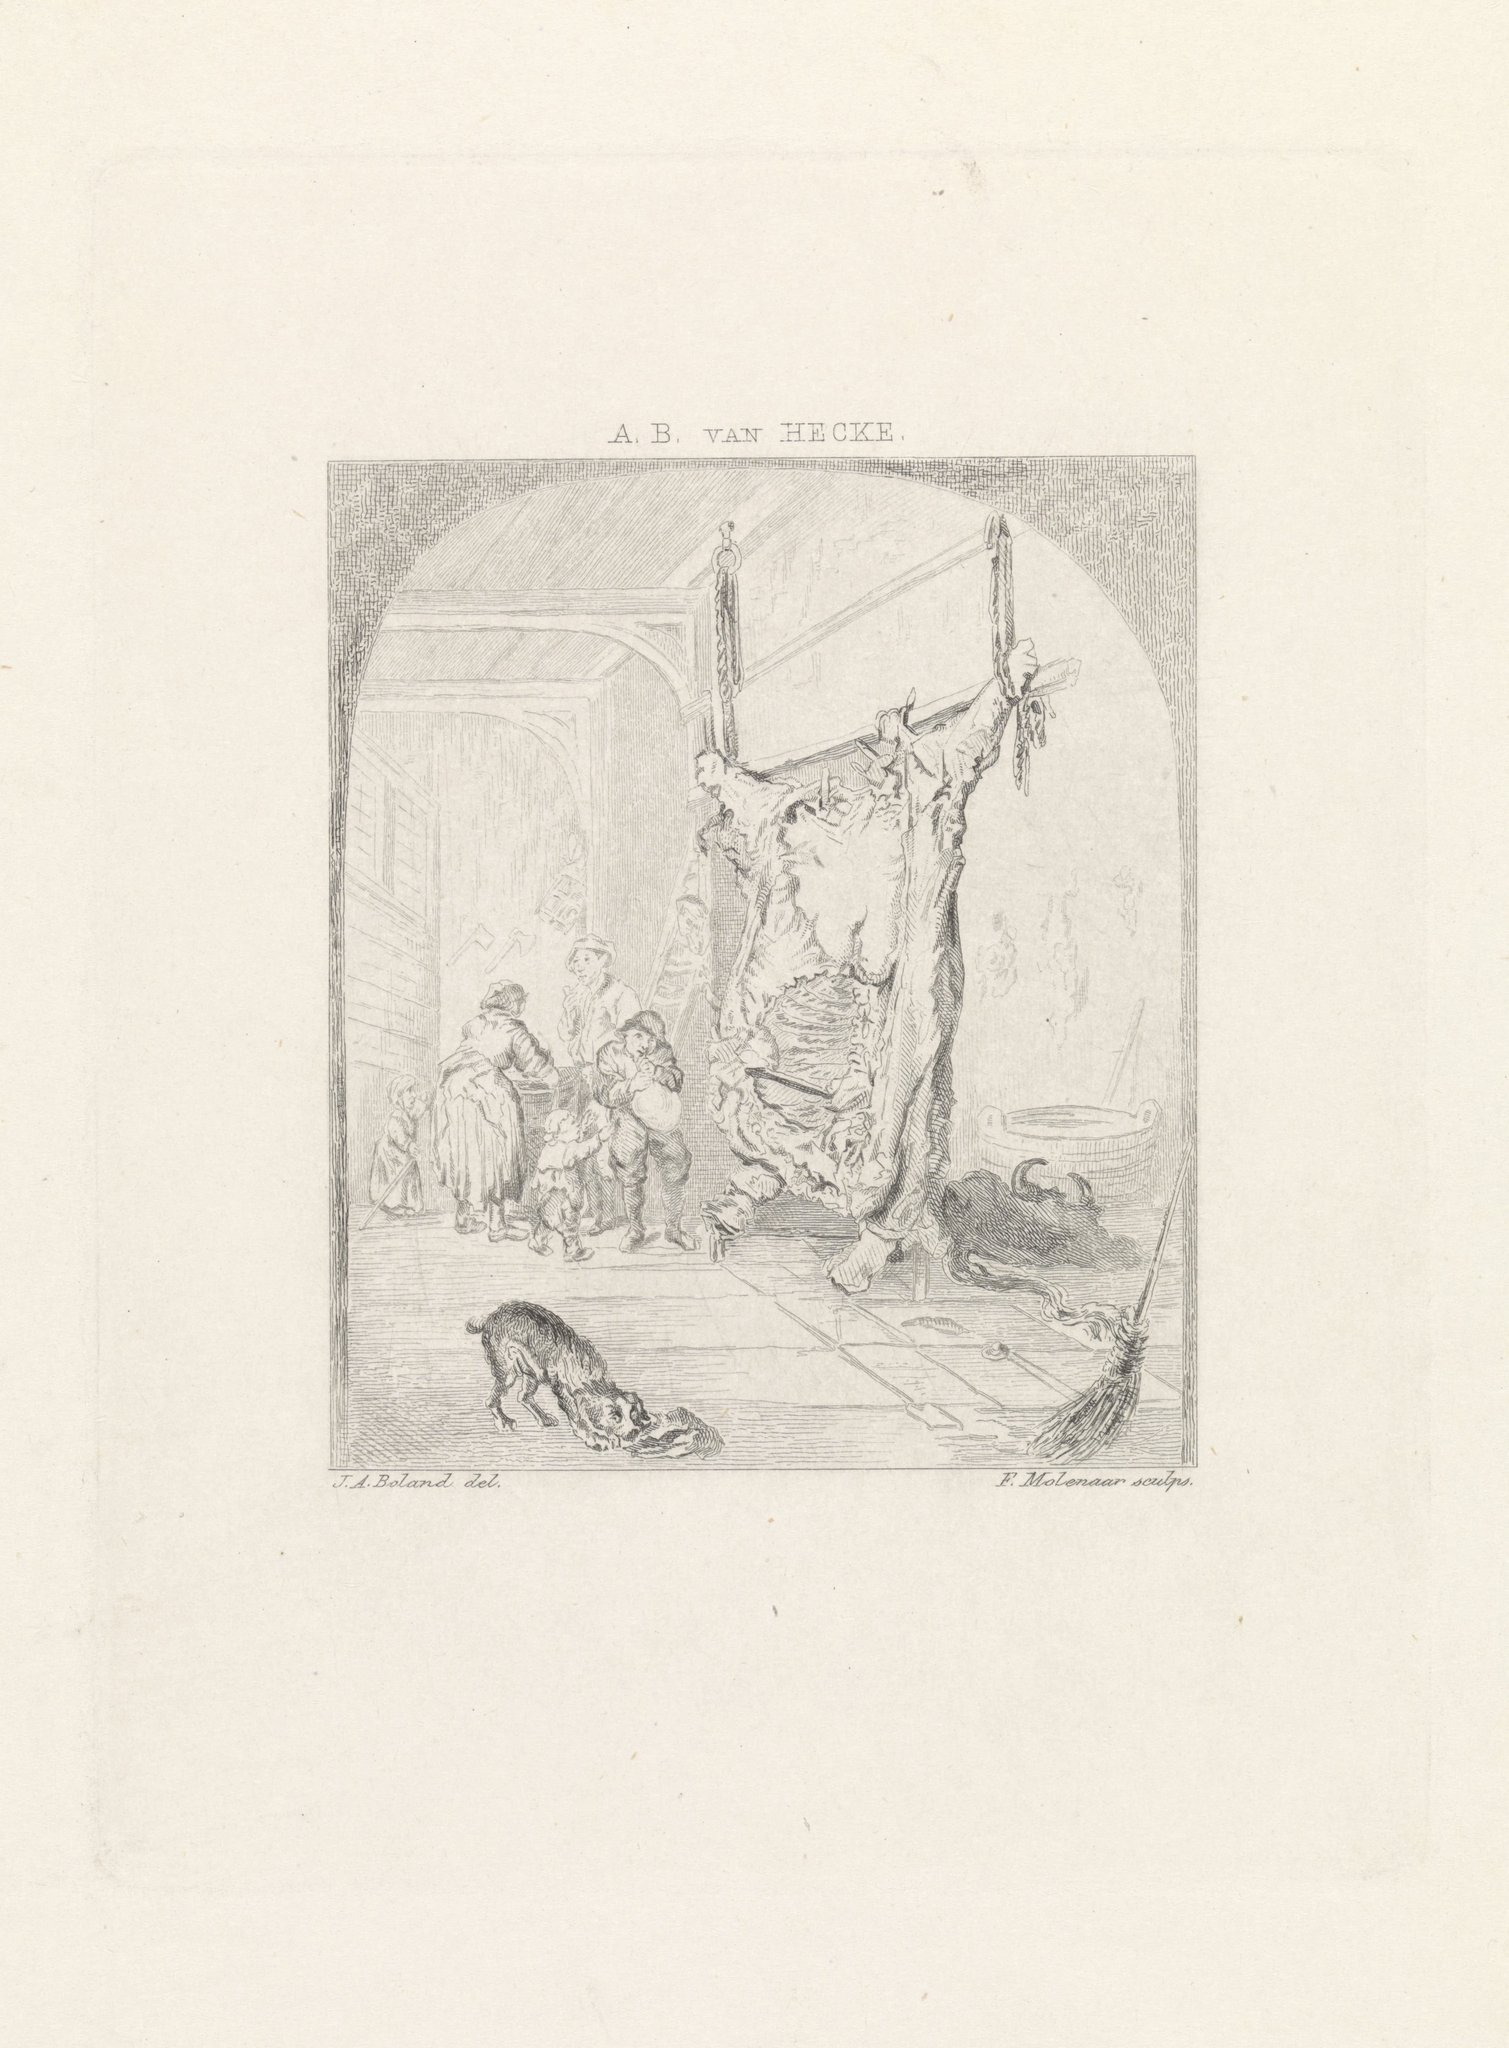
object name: print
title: Geslachte os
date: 1831-1886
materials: paper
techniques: etching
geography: amsterdam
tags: slaughtered ox or pig, dog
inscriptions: collector's mark: Lugt 2228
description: Interieur met een geslachte os hangend aan touwen aan het plafond. Op de voorgrond een hond met een stuk vlees. Op de achtergrond een man, vrouw en kinderen.